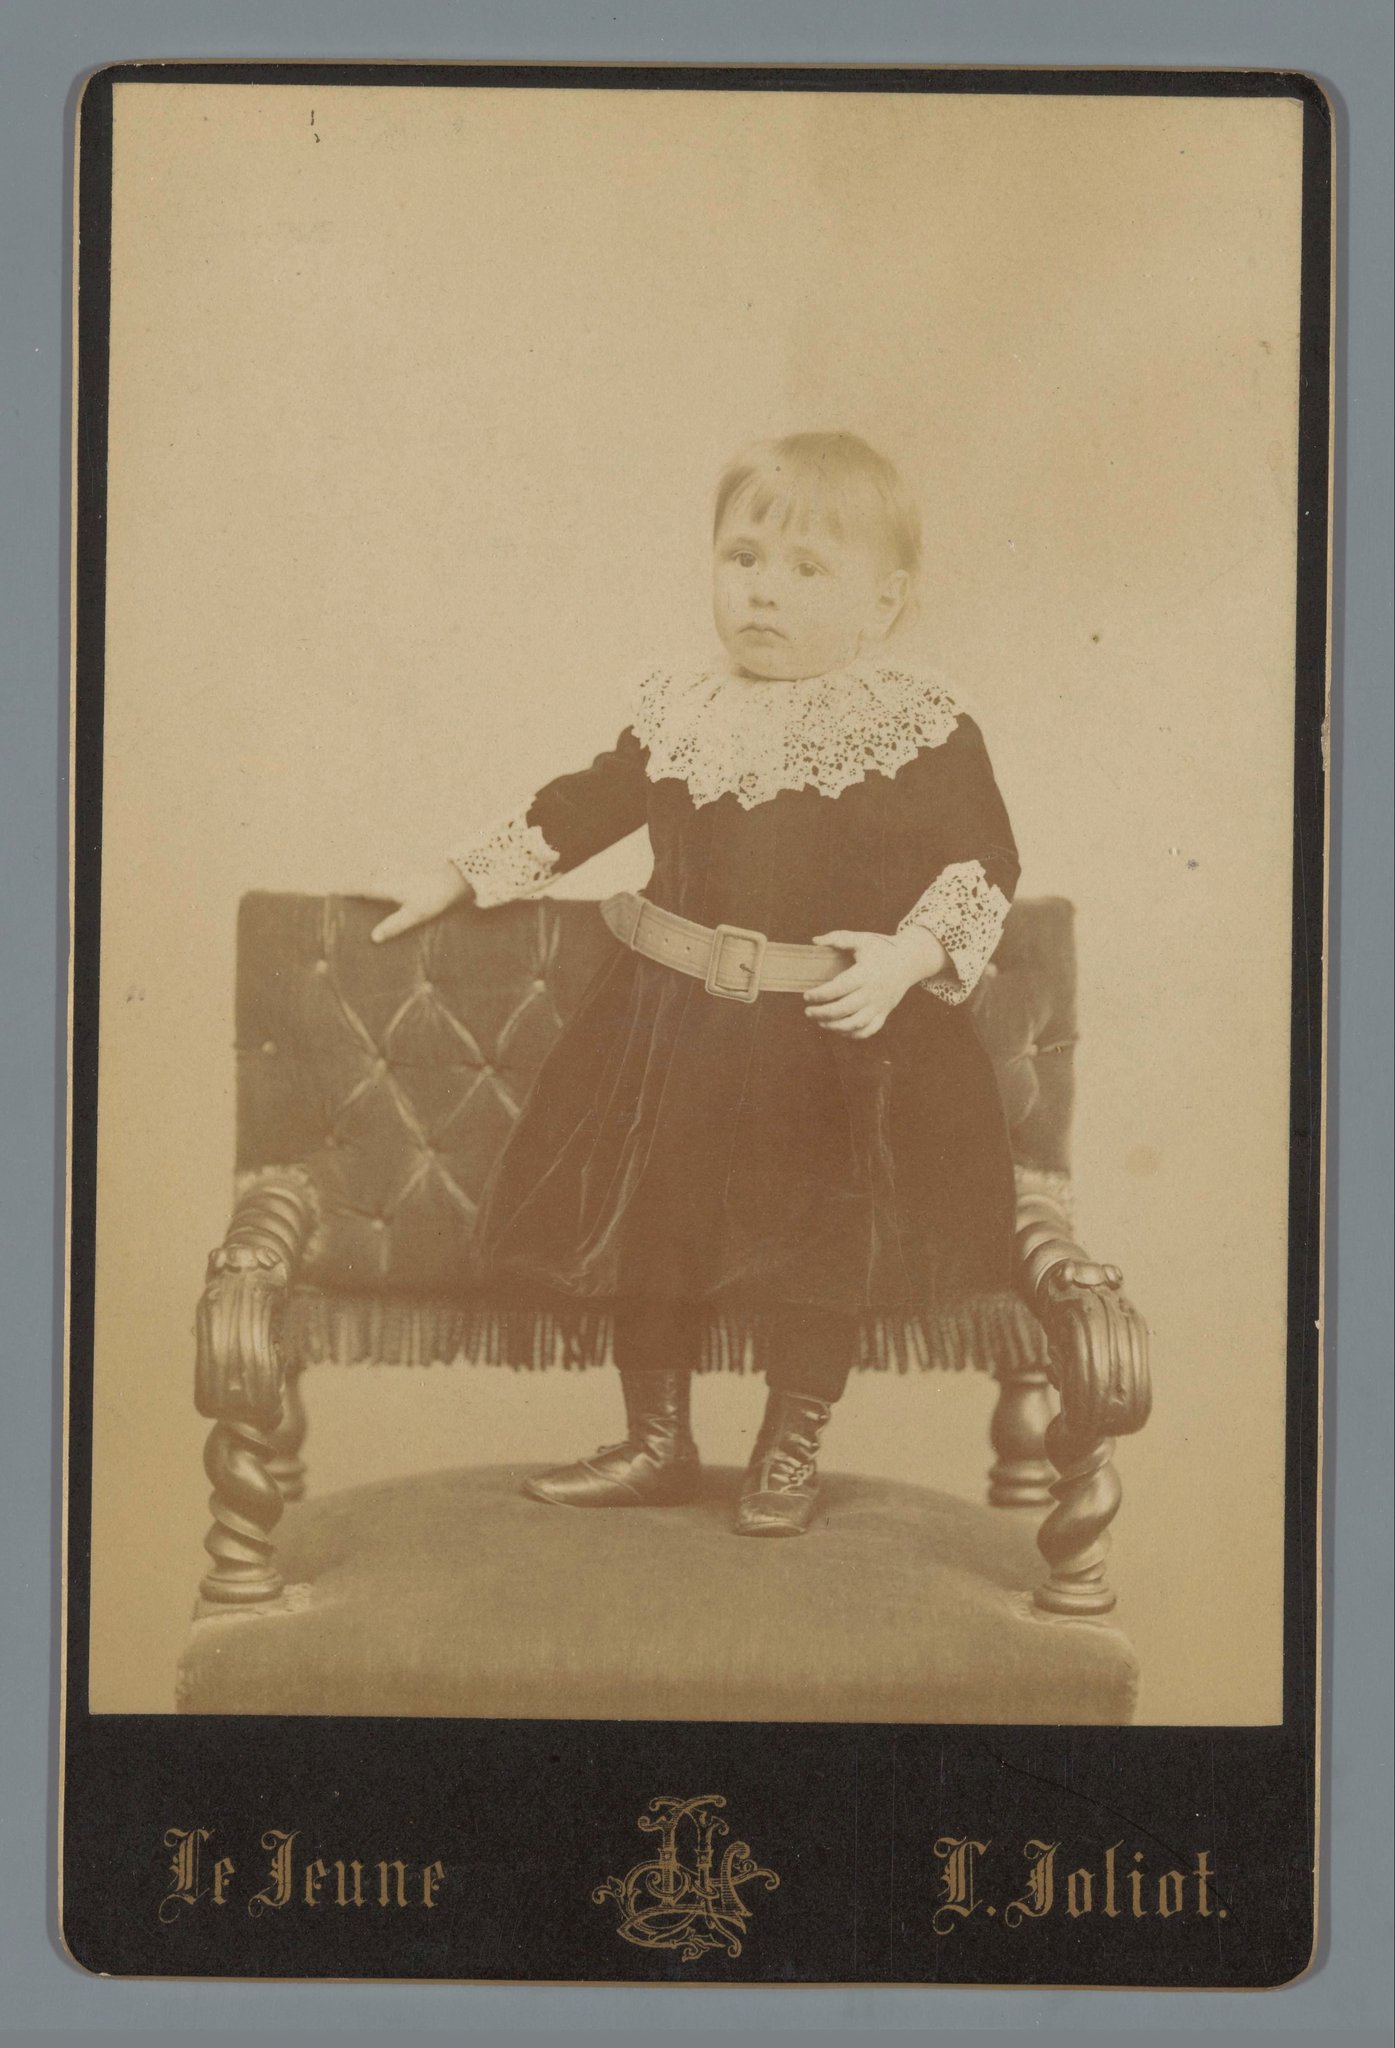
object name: cabinet photograph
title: Portret van een onbekend kind op een stoel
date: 1874-1900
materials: cardboard, photographic support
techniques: albumen print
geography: paris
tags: studio requisites ~ photographer, child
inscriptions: name: ‘Le Jeune L. Joliot, Succr. 350, Rue St. Honoré, 350 près la PLace Vendôme. Paris.’